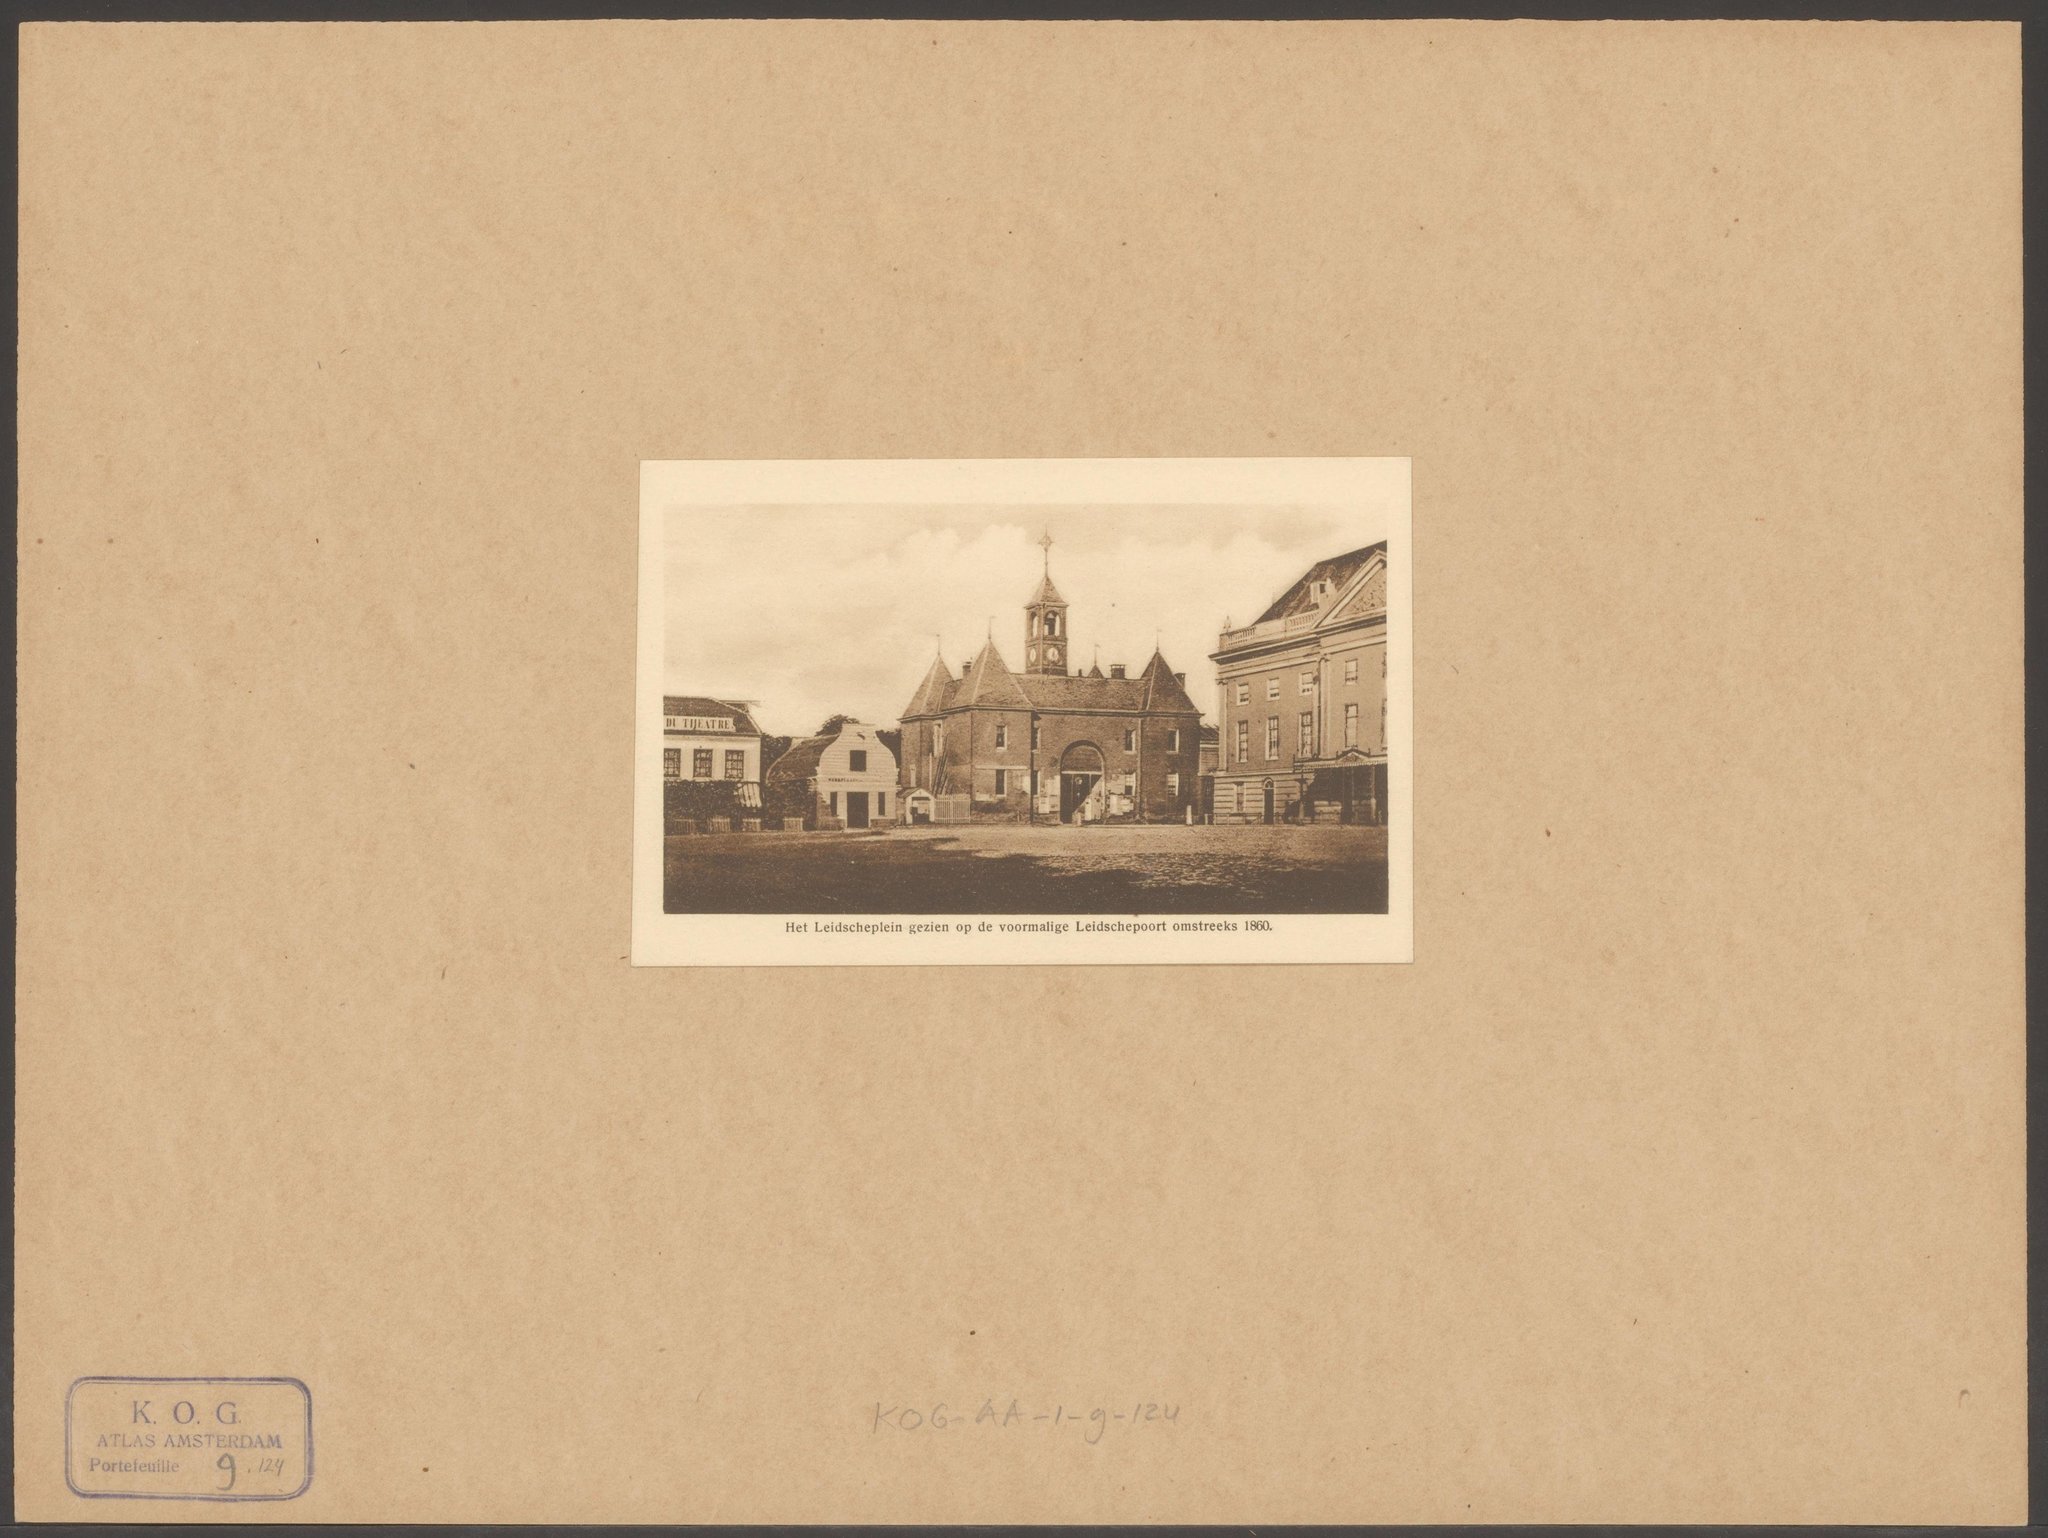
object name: ansichtkaart, prentbriefkaart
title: Gezicht op de Leidsepoort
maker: Anonymous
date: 1905-1930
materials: cardboard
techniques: photograph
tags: square, place, circus, etc., city-view in general; 'veduta', city-gate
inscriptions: collector's mark: ‘9.124’ Lugt 1641b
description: Onderwerpsrubriek binnen de Atlas Amsterdam: 2e Laurierdwarsstraat (Vuile Weespad), Leidschegracht, Leidschekade, Leidscheplein, Leidschestraat, v. Lennepkade, Lijnbaansgracht, Lauriergracht, Leliedwarsstraat, Leliegracht, Lindengracht, Lombardsteeg, Looiersgracht, Looiersstraat (Nieuwe), Leidekkerssteeg.